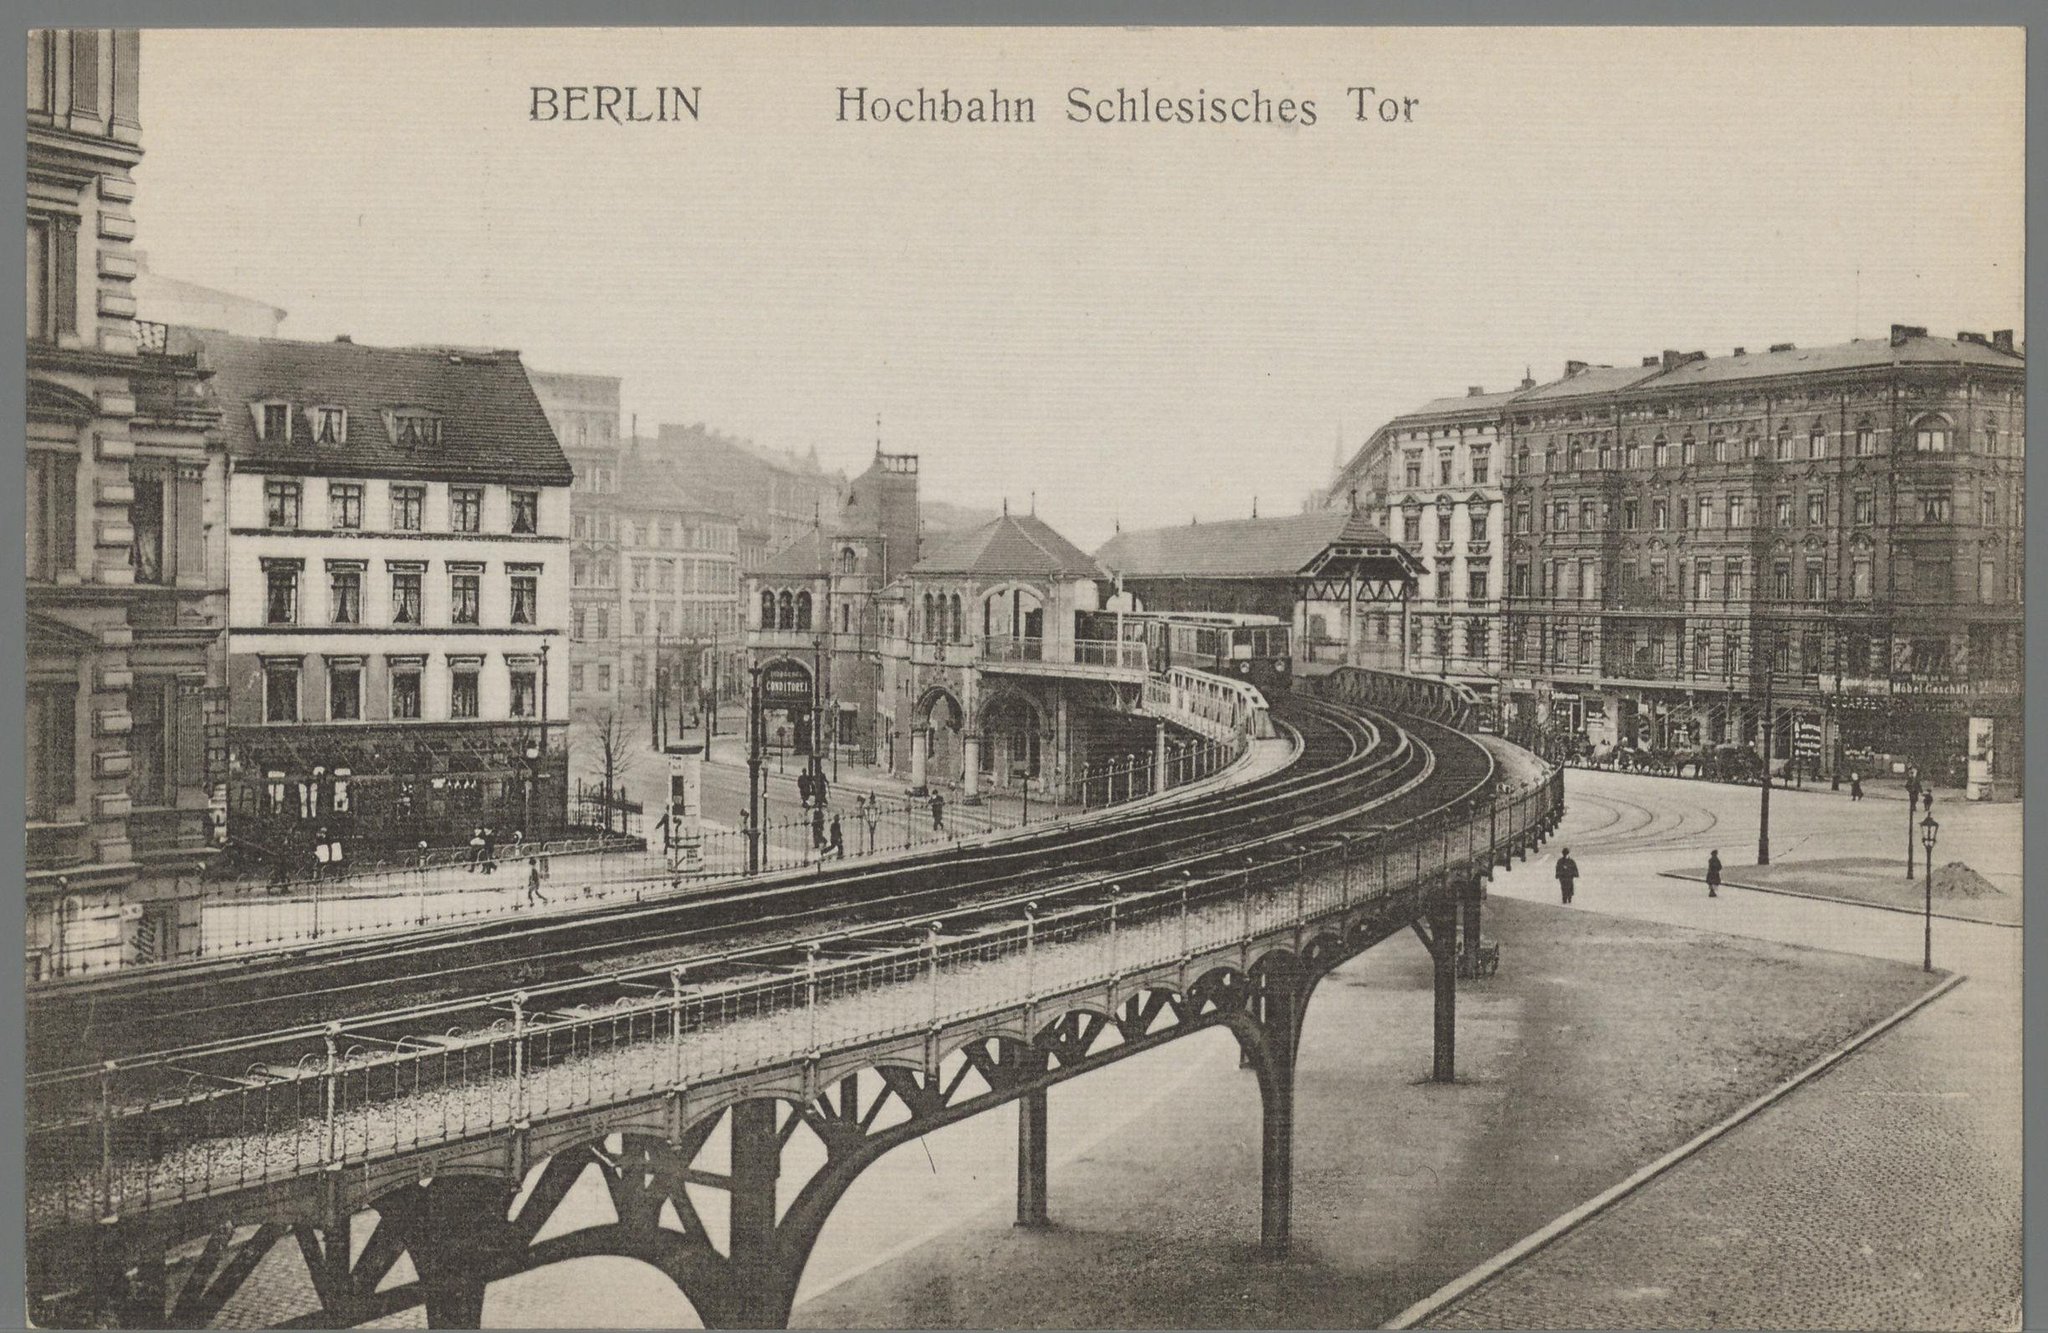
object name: photomechanical print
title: Berlin. Hochbahn Schlesisches Tor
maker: Anonymous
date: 1905-1930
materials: cardboard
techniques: photograph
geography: berlin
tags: city-view, and landscape with man-made constructions, railway, train, berlin